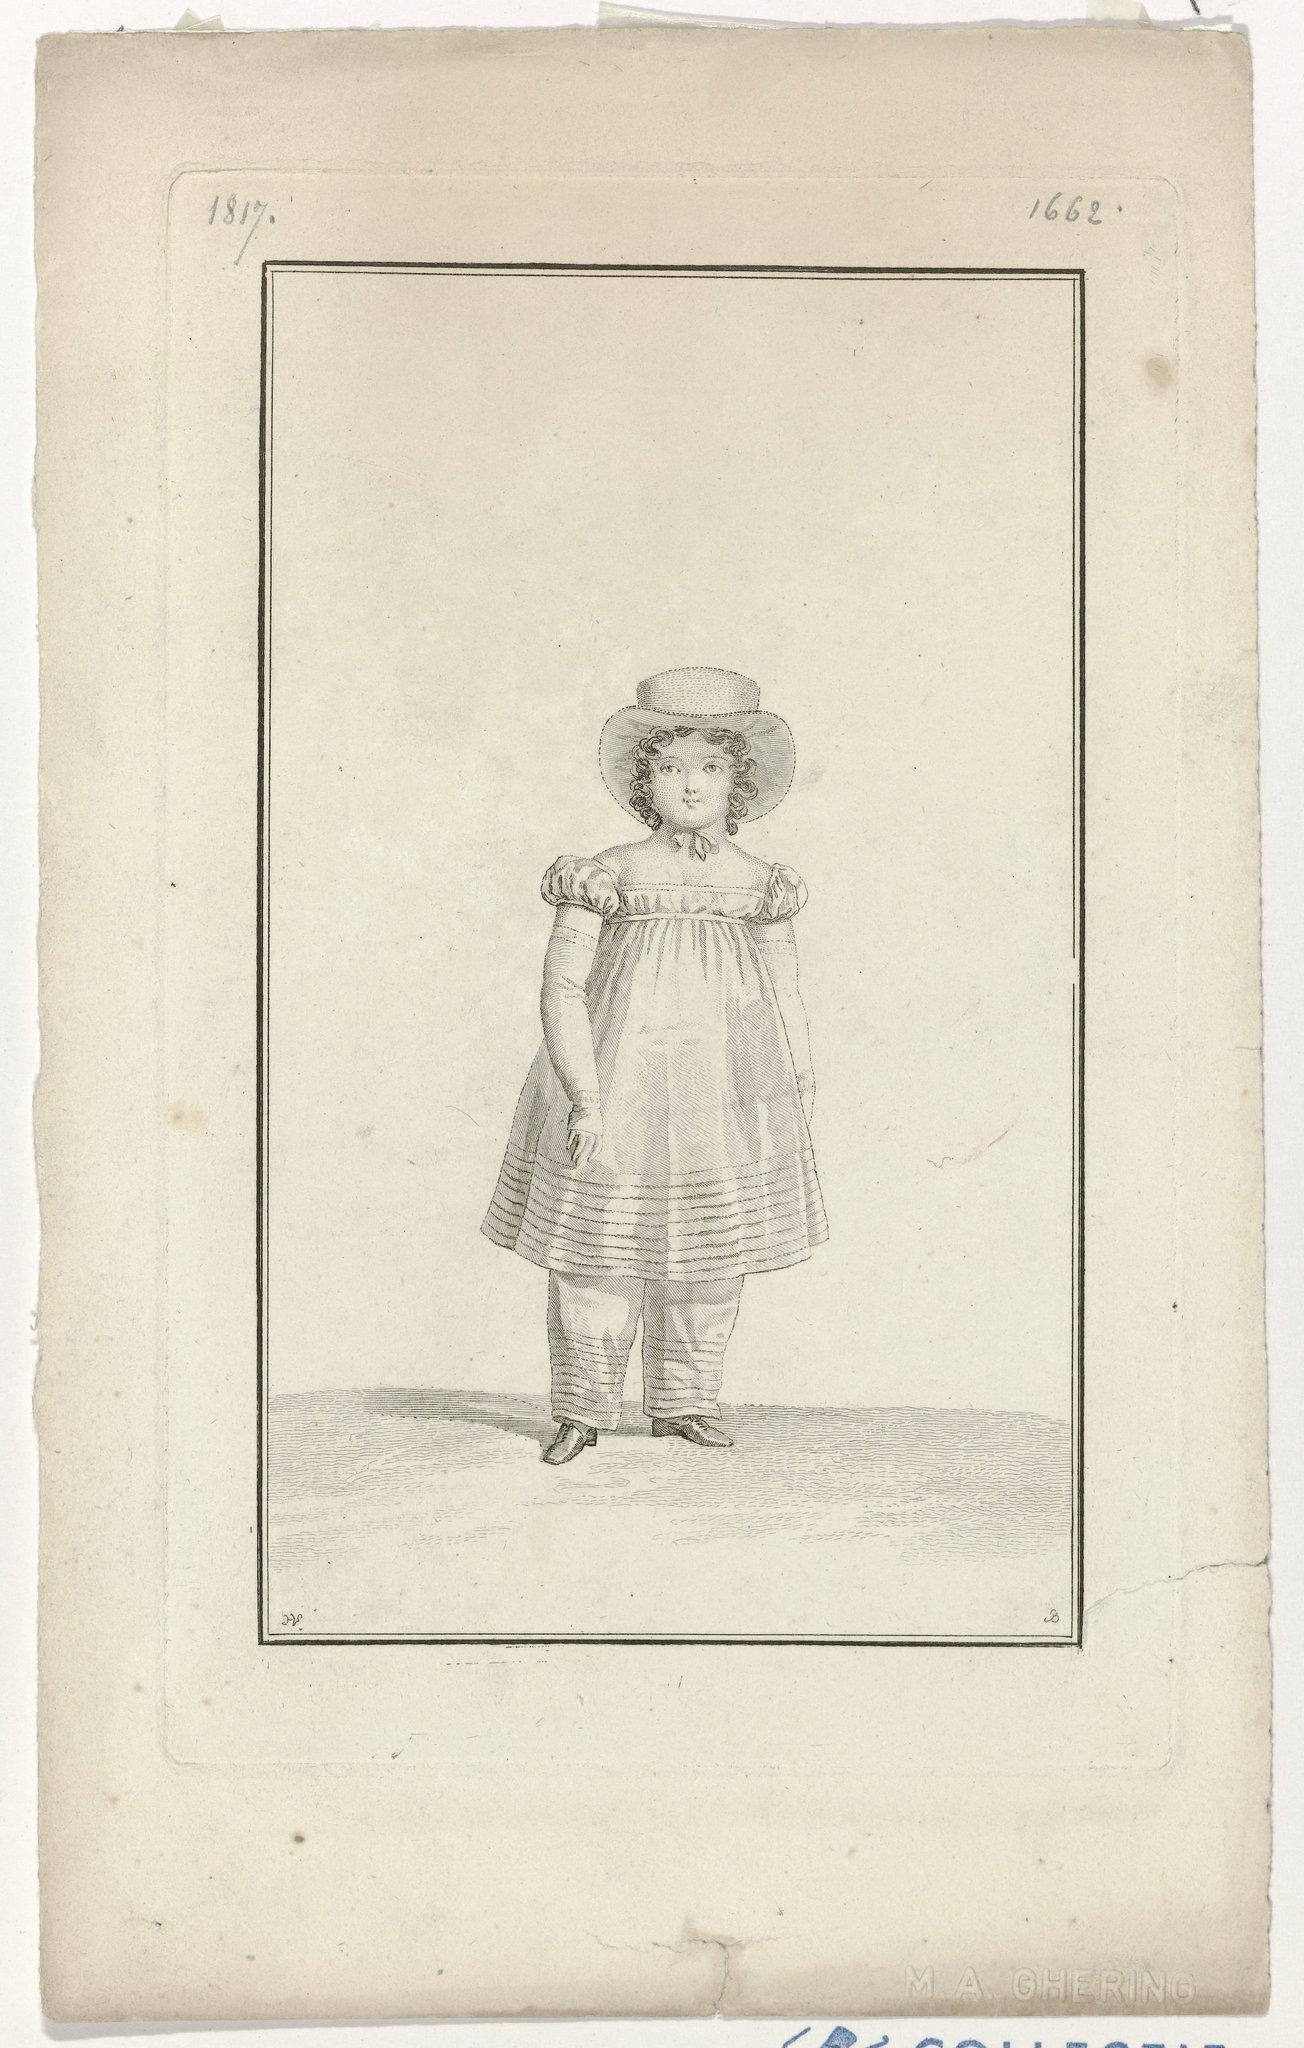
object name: fashion print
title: Journal des Dames et des Modes, Costume Parisien, 15 juillet 1817, (1662)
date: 1817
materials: paper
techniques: engraving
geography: paris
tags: head-gear (+ girls' clothes), shoes, sandals (+ girls' clothes), underclothes for the lower part of the body: bloomers (+ girls' clothes), gloves, mittens, etc. (+ girls' clothes), fashion plates, dress, gown (+ girls' clothes)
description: Meisje met op het hoofd een strohoed. Zij draagt een japon en lange broek (bloomers) van katoenbatist (percale). Schoenen met rijgsluiting. Proefdruk van een prent uit van het modetijdschrift Journal des Dames et des Modes, uitgegeven door Pierre de la Mésangère, Parijs, 1797-1839.